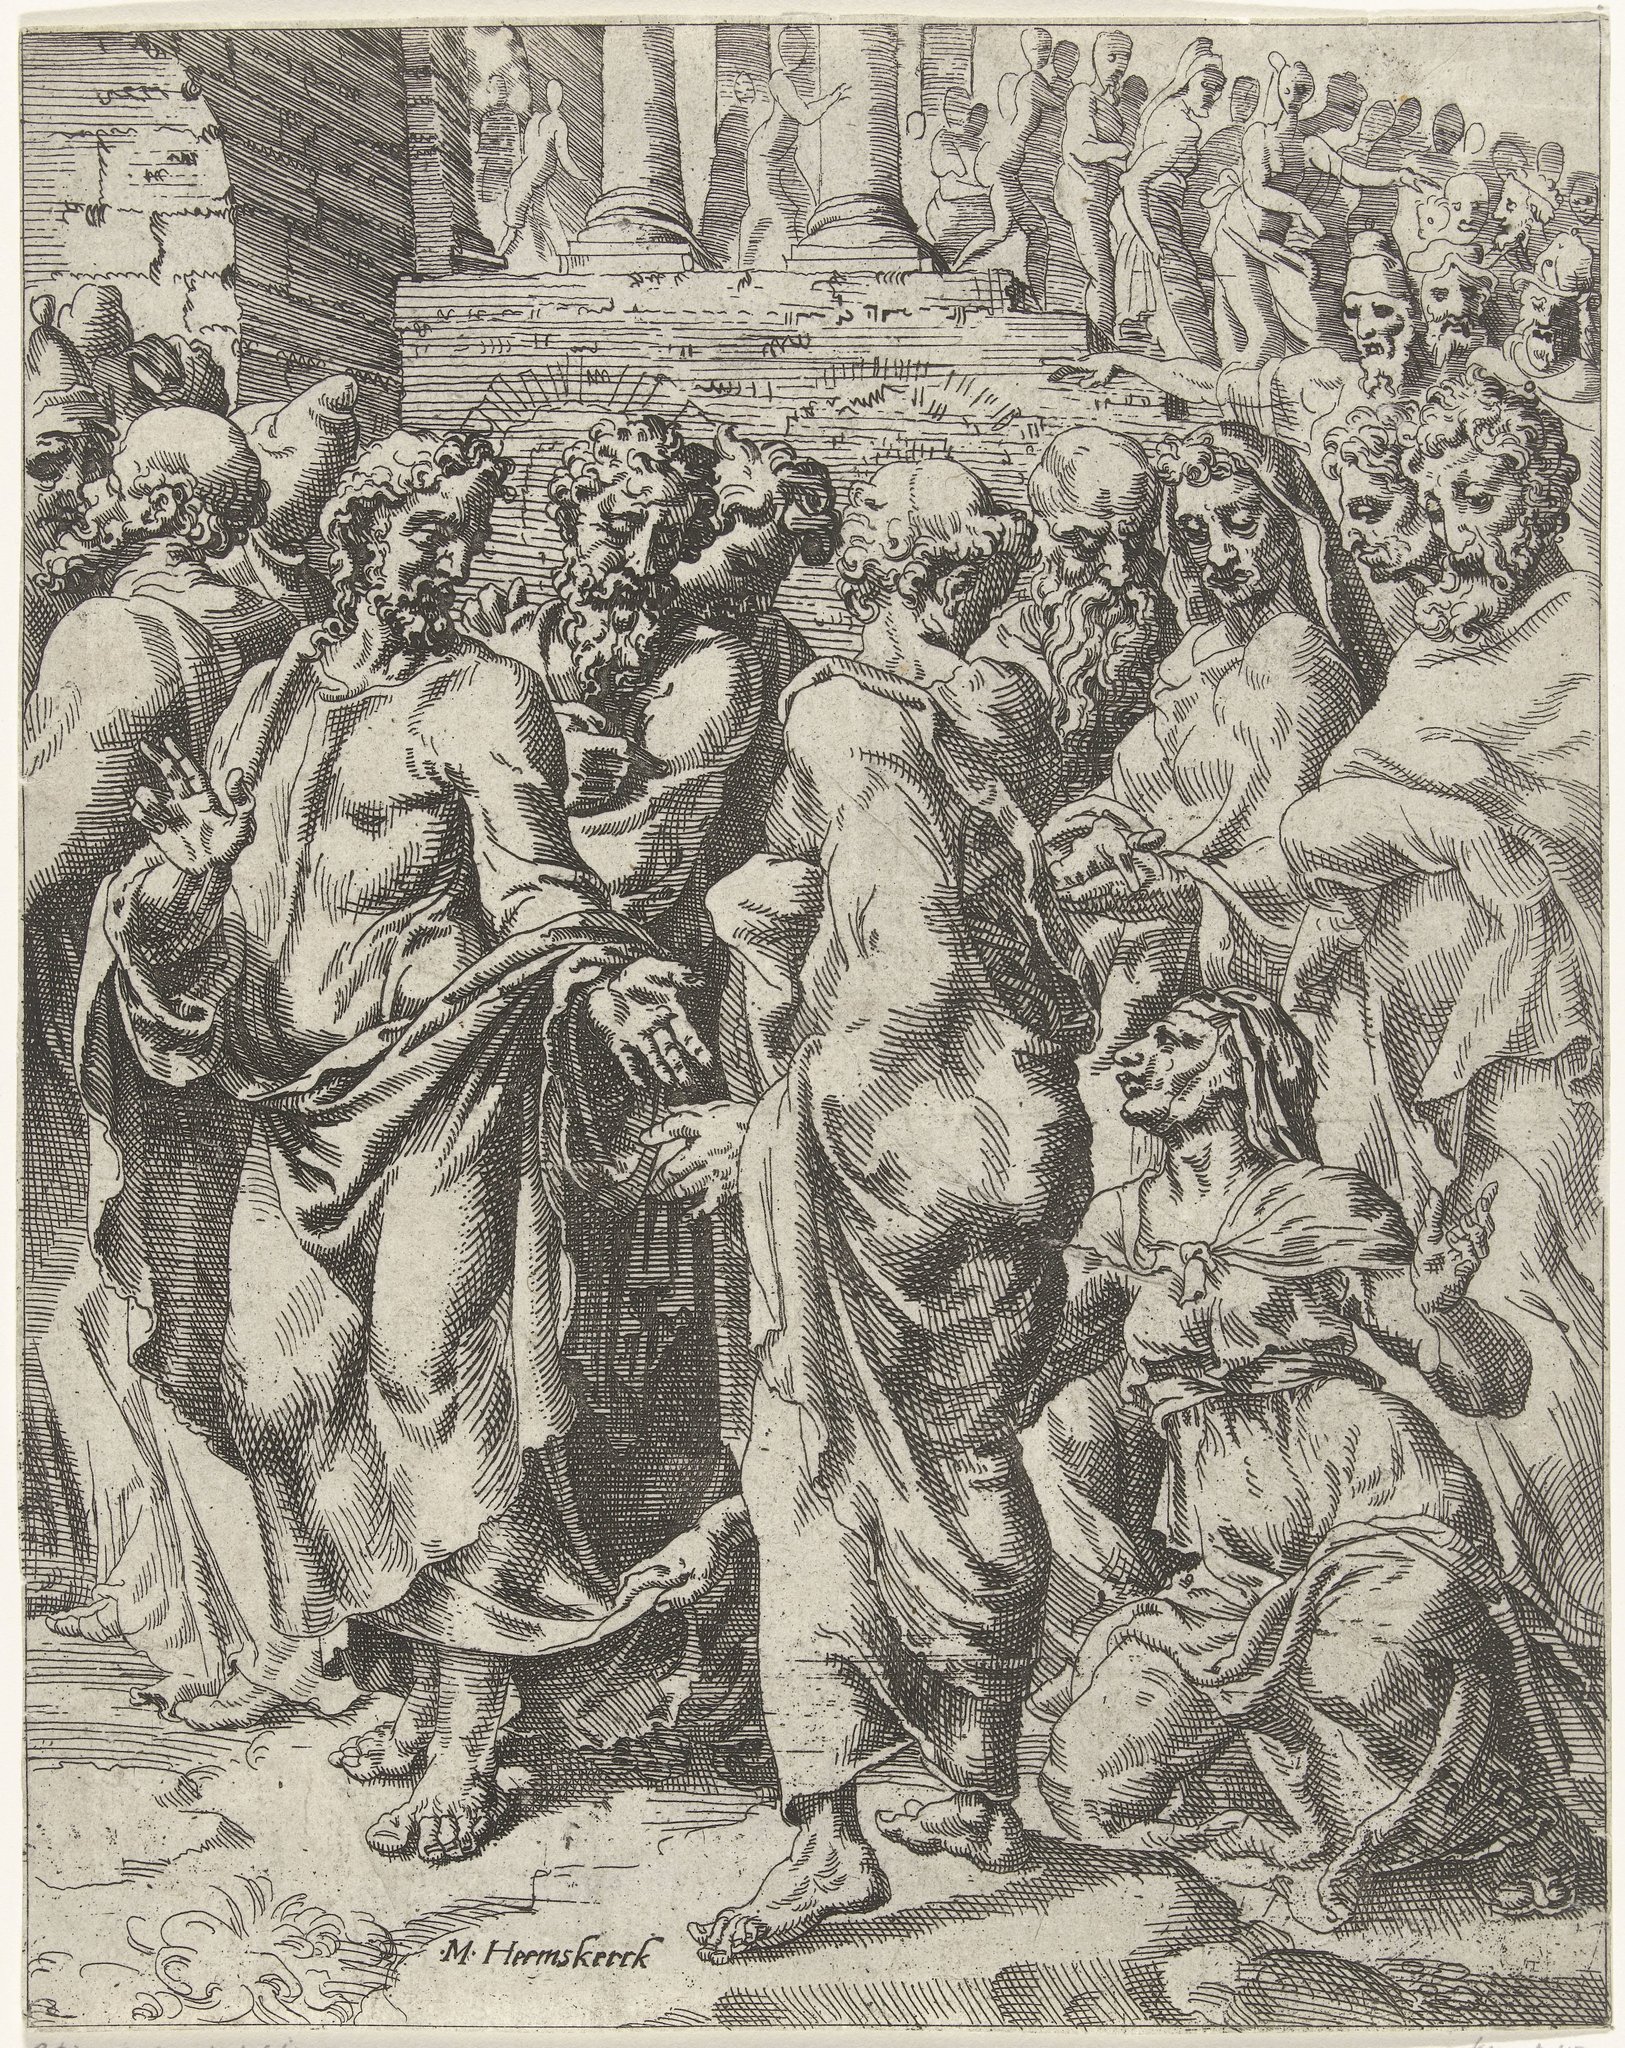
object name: print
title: Genezing van de vrouw die aan bloedvloeiingen leed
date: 1548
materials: paper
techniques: etching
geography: haarlem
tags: healing of a woman with an issue of blood: she kneels before christ after having touched his robe (matthew 9:20-22; mark 5:25-34; luke 8:43-48)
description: Een vrouw die lijdt aan voortdurend bloedverlies raakt de zoom van het kleed van Christus aan. Christus draait zich om en geneest haar. Rondom hen de apostelen. De prent is deel van een dertigdelige serie met prenten over de zondeval en Christus' passie.